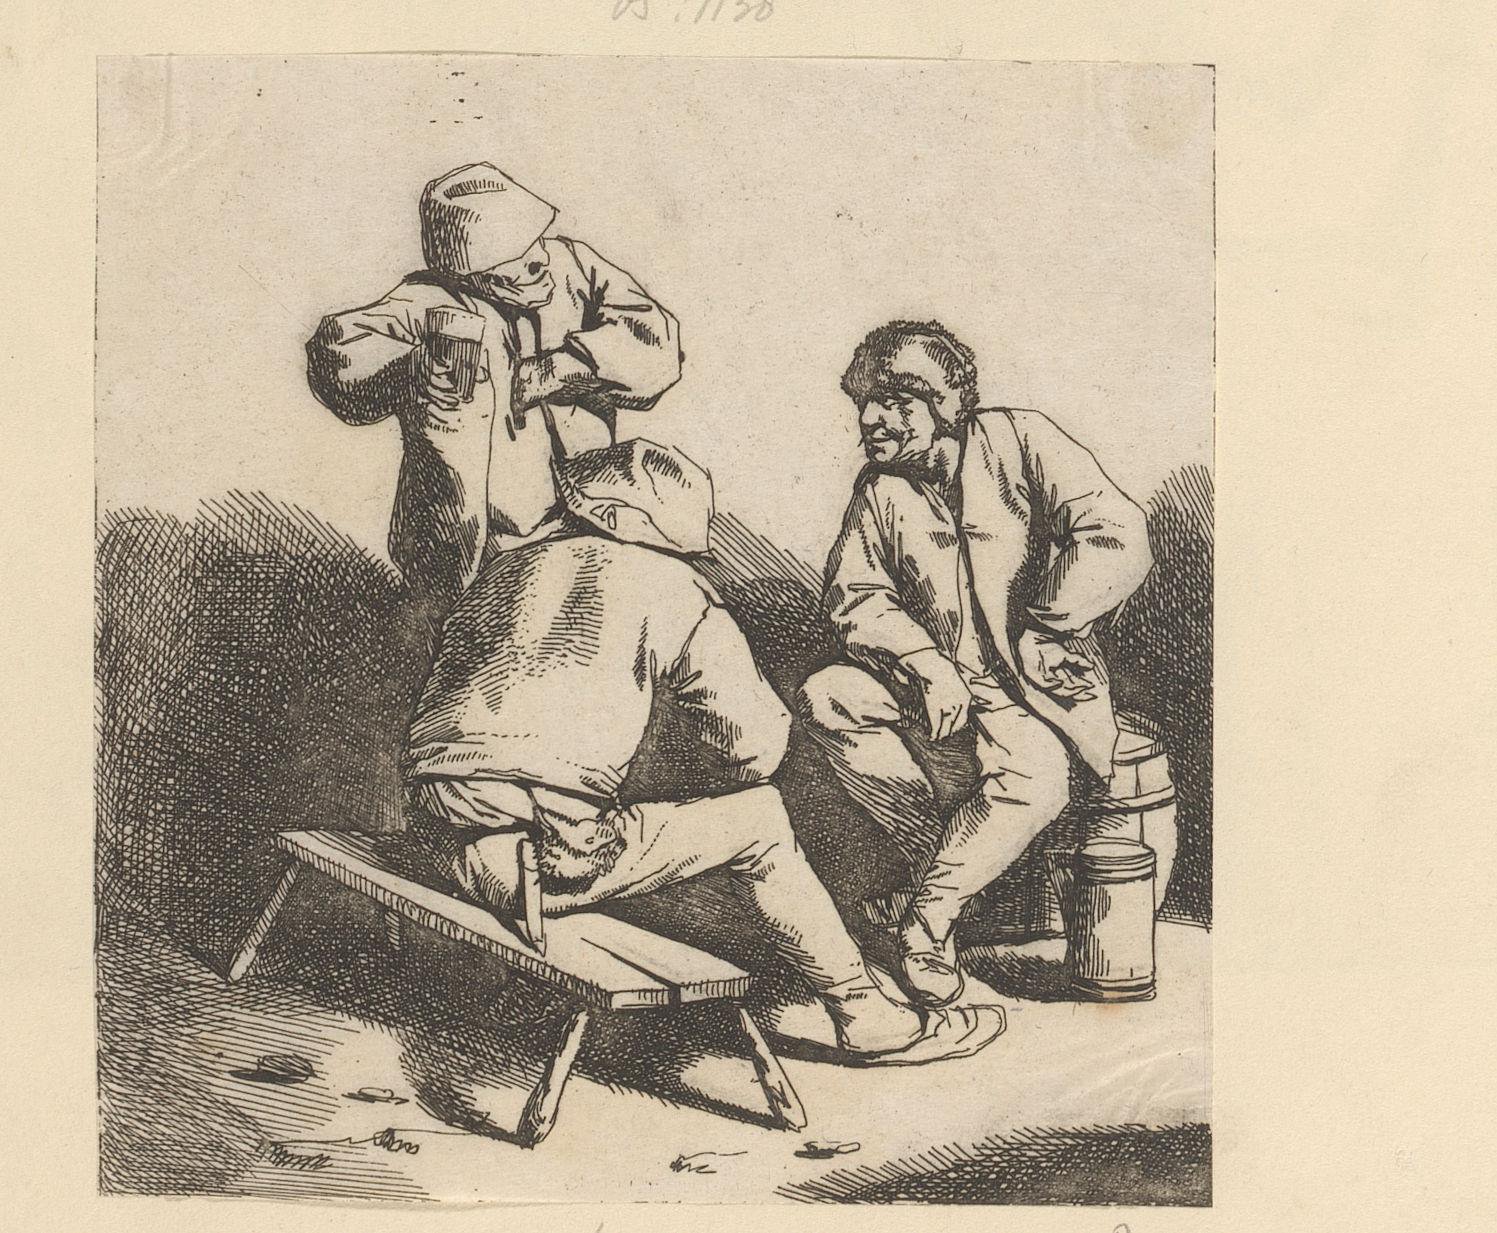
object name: album leaf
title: Drie drinkende mannen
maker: cornelis pietersz. bega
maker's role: draughtsman, painter, print maker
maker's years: 1631-1664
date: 1641-1664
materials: paper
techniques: etching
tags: drinks, stimulants, drugs, hotel, hostelry, inn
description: Prent maakt mogelijk deel uit van een serie van 200 prenten. Deze serie is onder de titel 'A Collection of two hundred original etchings' voor het eerst uitgegeven door J.M. Greery in 1816.